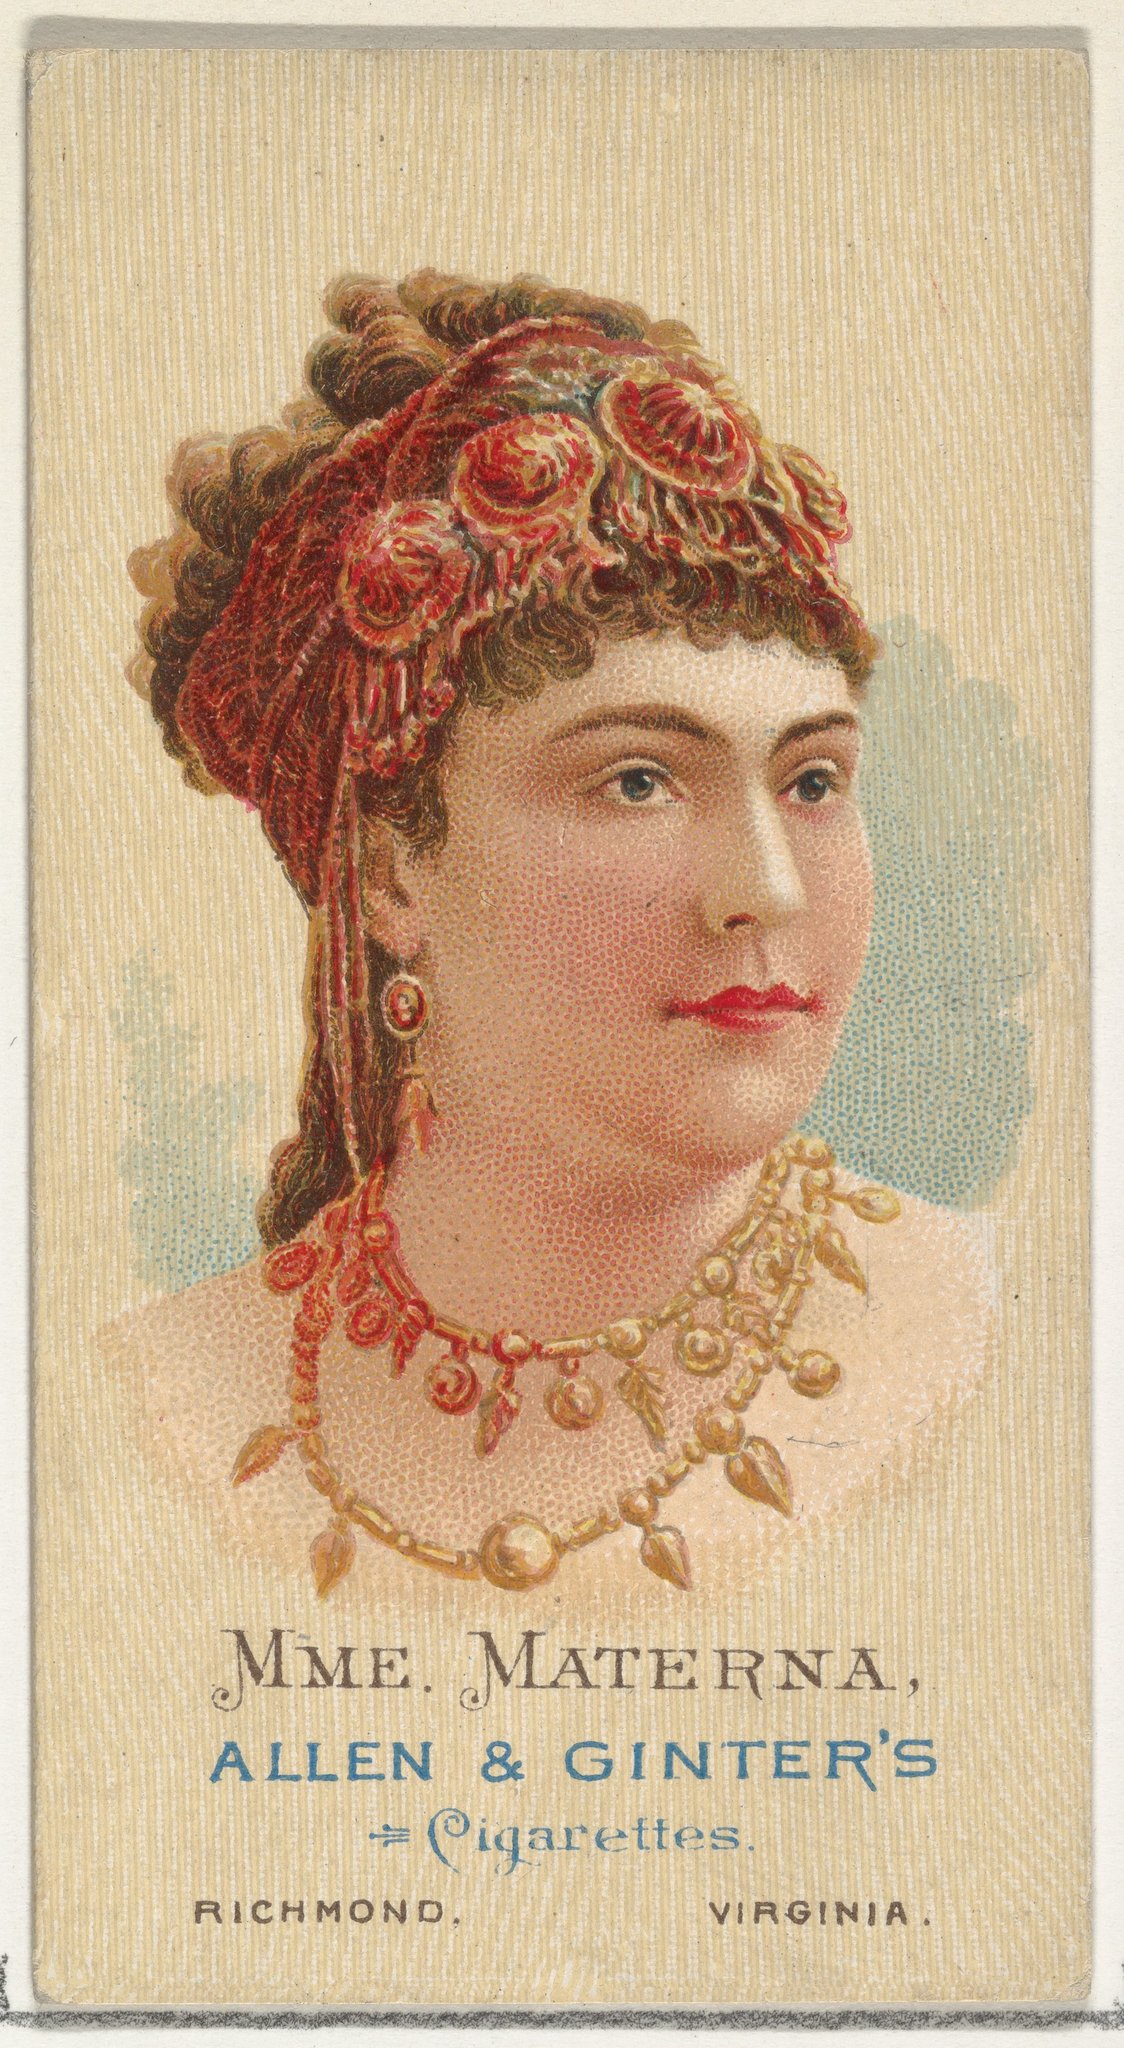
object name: print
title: Mme. Materna, from World's Beauties, Series 2 (N27) for Allen & Ginter Cigarettes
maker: allen & ginter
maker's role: publisher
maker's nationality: american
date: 1888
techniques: color lithograph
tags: women